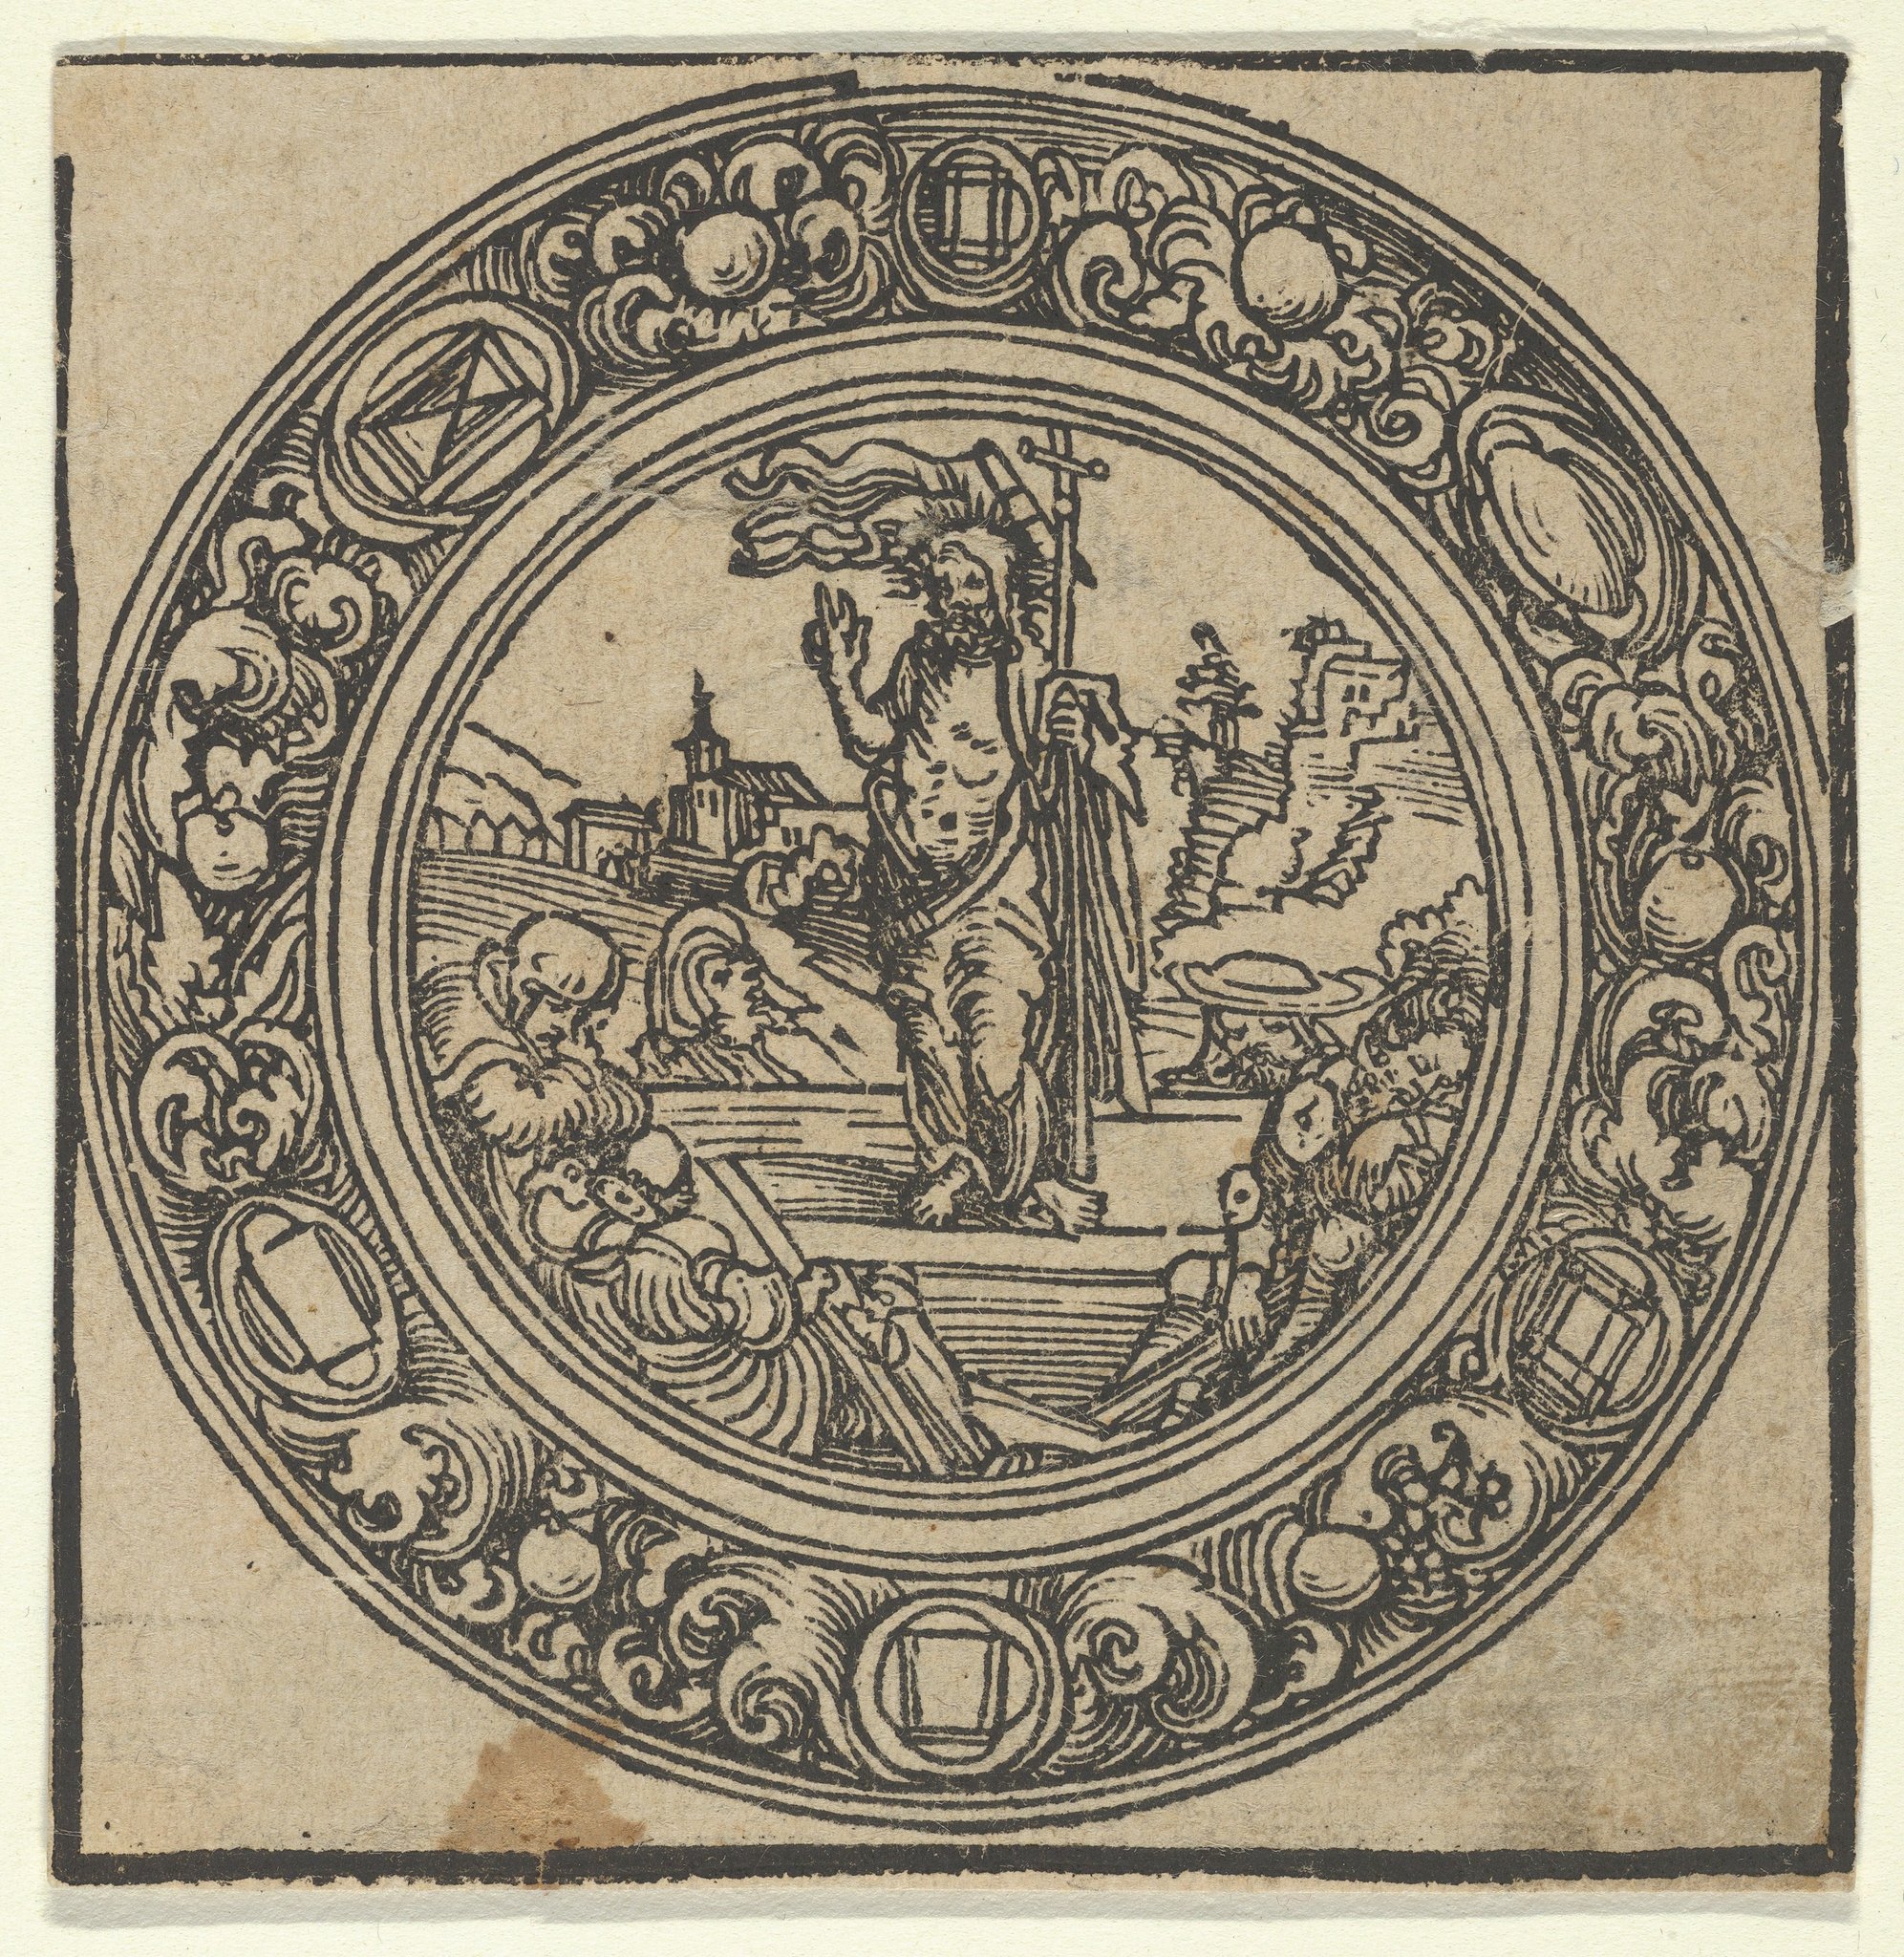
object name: print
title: Pacifical with Resurrection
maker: lucas cranach the elder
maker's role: artist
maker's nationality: german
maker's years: 1472-1553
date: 1472-1553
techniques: woodcut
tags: men,christ,cross